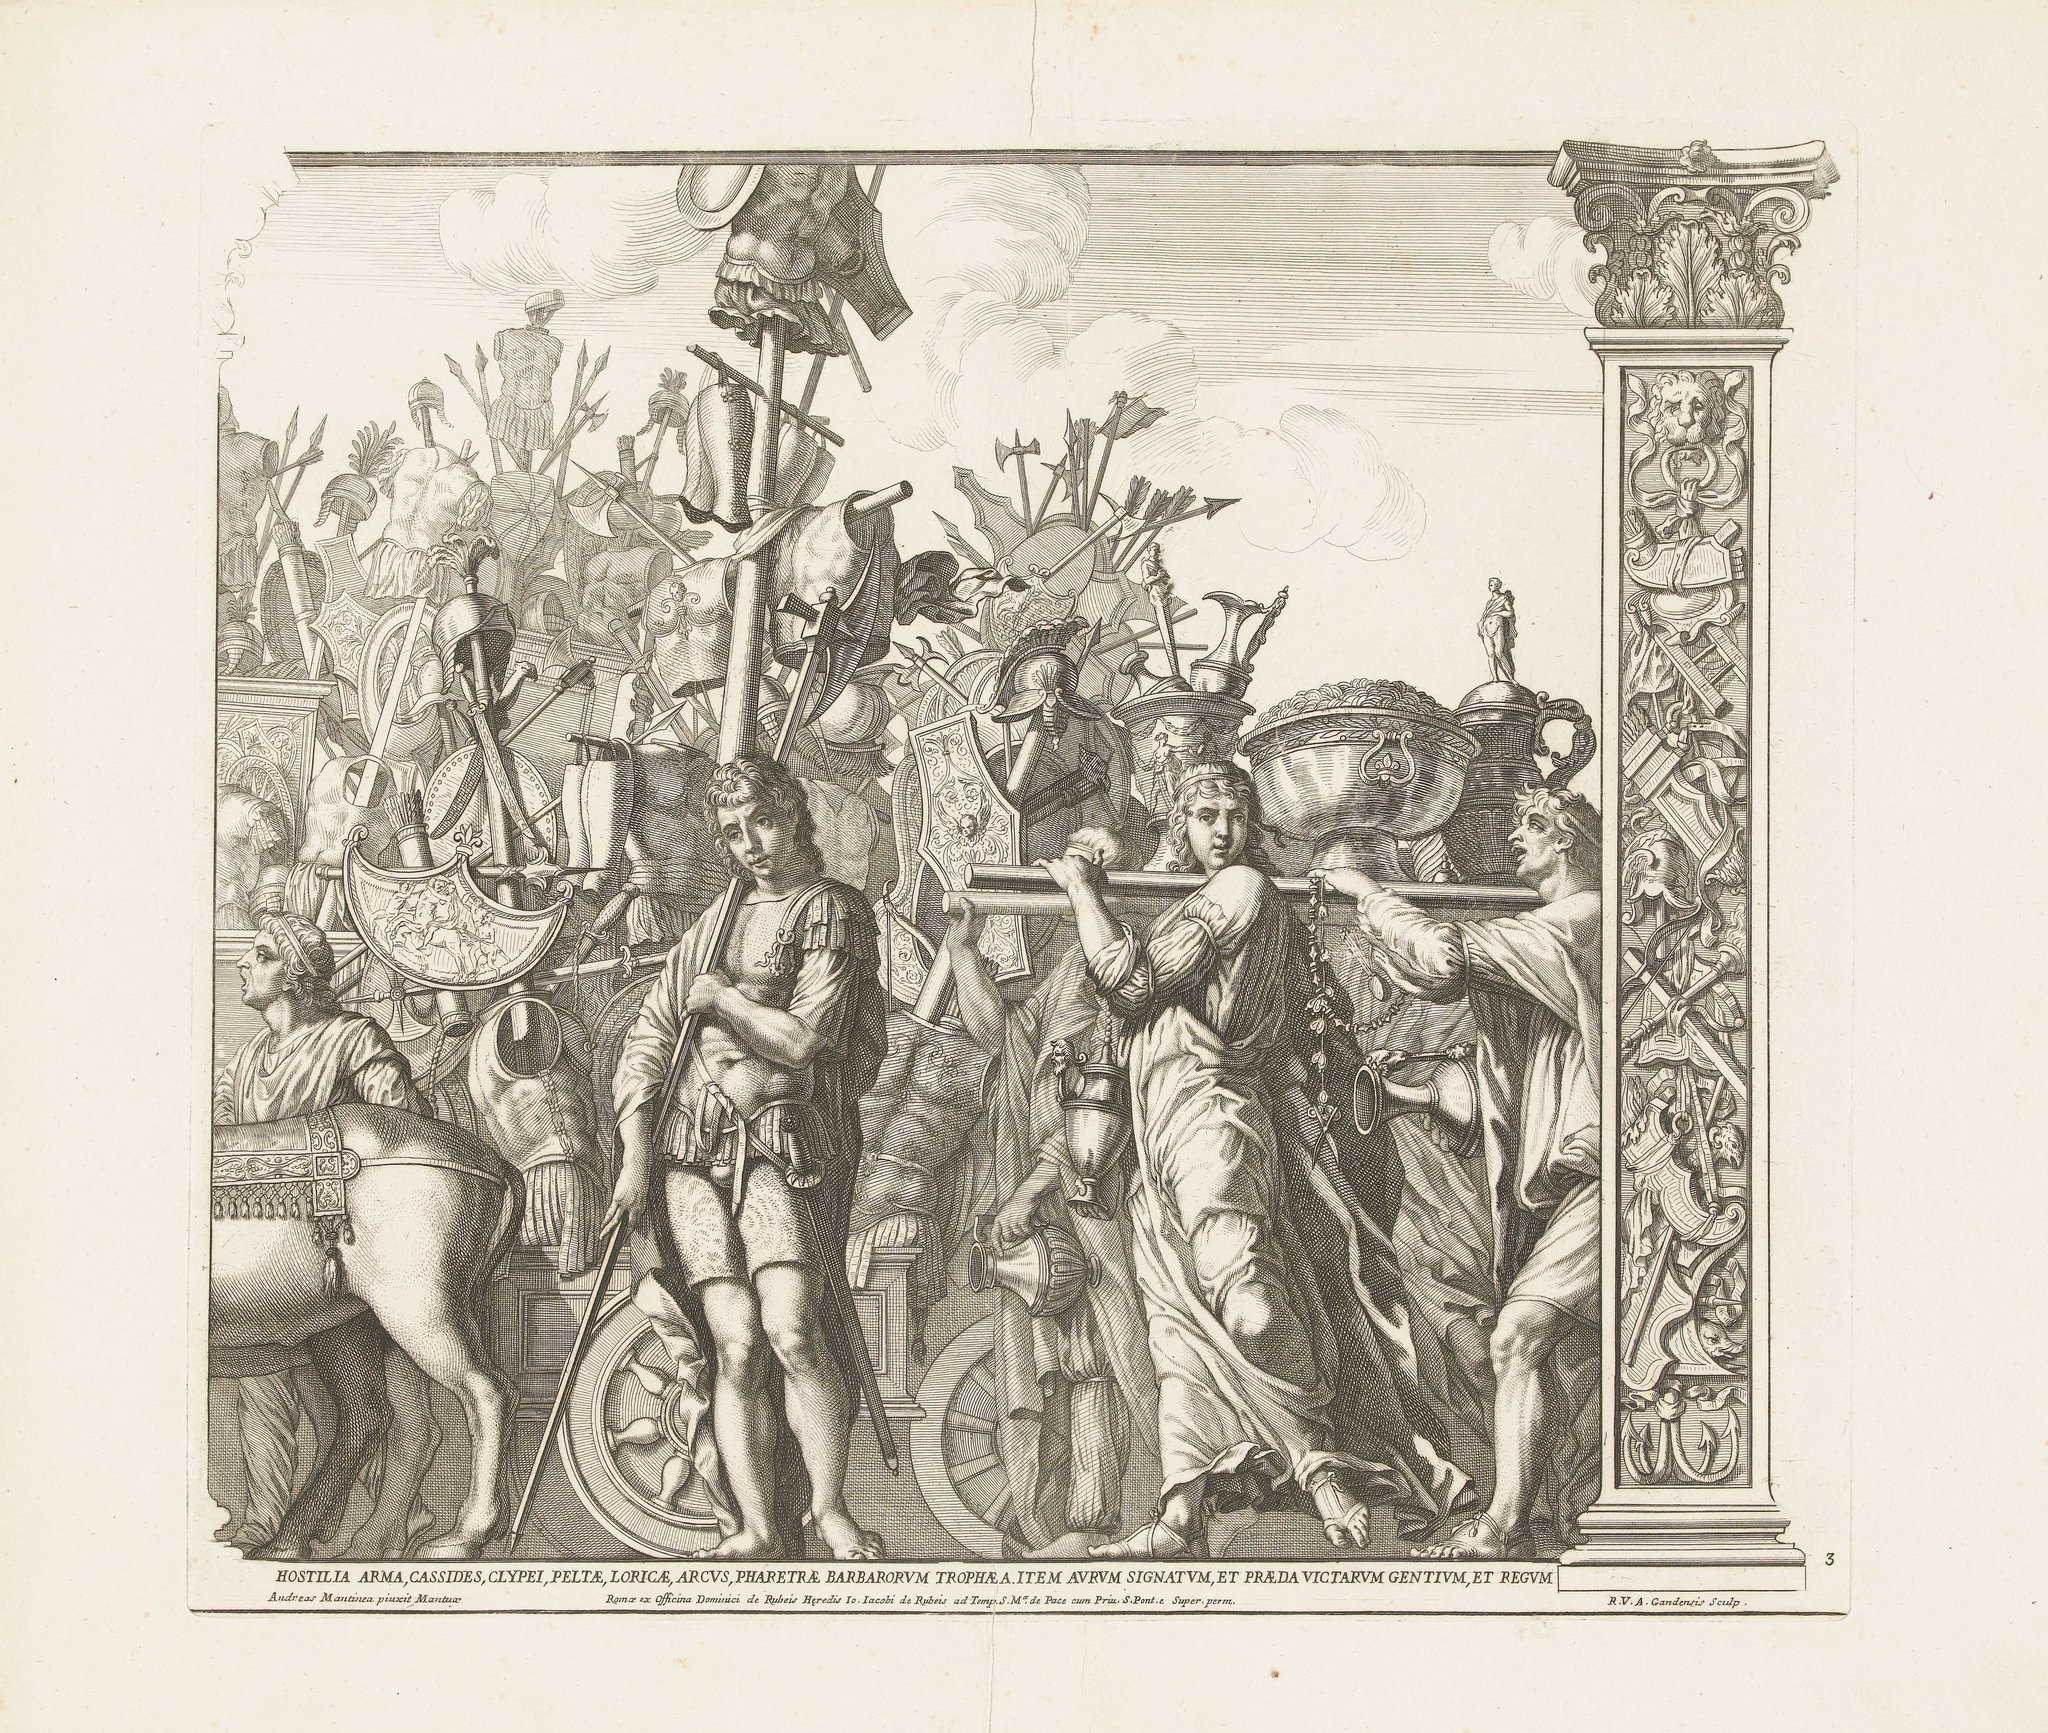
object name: print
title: Soldaten dragen de buit gemaakte uitrusting van de vijanden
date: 1692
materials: paper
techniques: engraving, etching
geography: mantua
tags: triumph of caesar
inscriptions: collector's mark: Lugt 240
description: Soldaten dragen de buit gemaakte uitrusting van de vijanden mee in een optocht ter ere van Julius Caesar. Harnassen, helmen en wapens zijn aan stokken opgehangen en worden getoond aan het publiek.